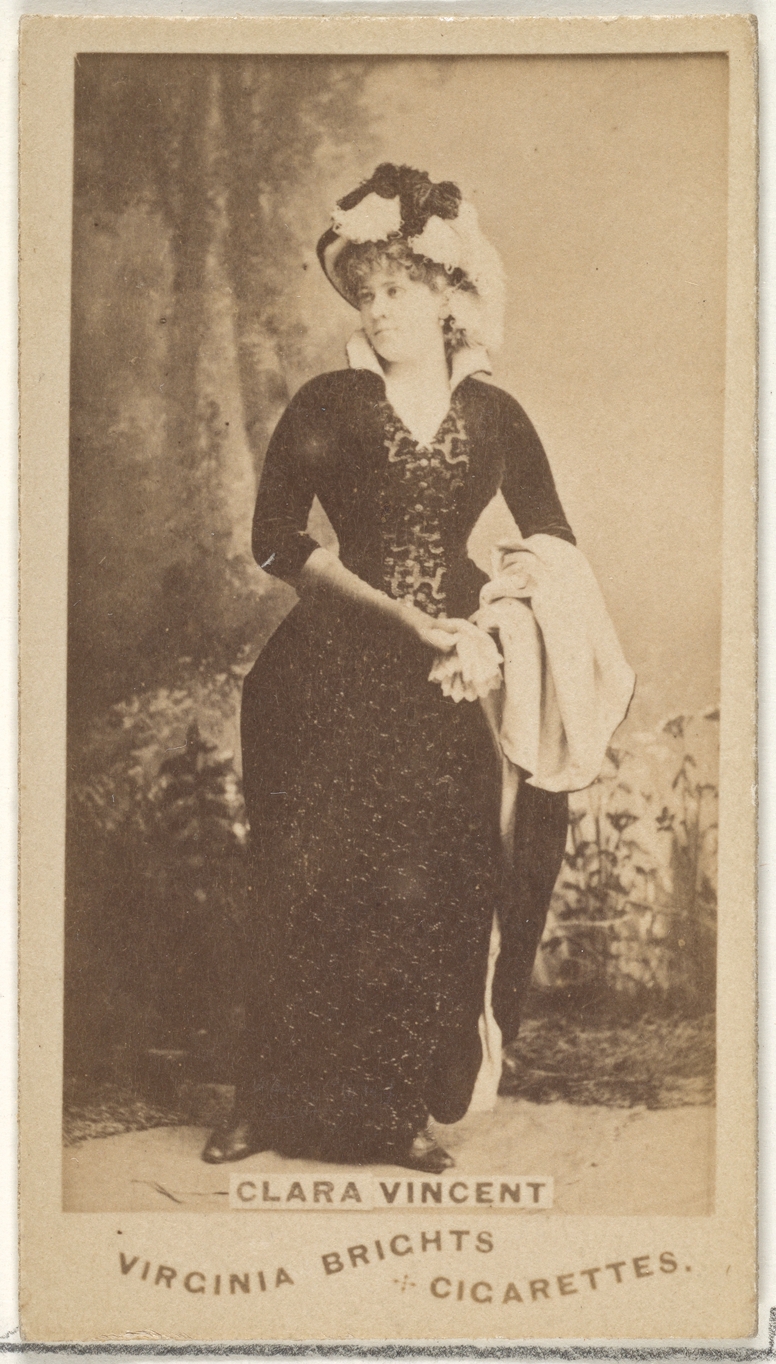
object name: photograph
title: Clara Vincent, from the Actors and Actresses series (N45, Type 1) for Virginia Brights Cigarettes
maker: allen & ginter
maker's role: publisher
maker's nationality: american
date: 1888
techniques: albumen silver print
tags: portraits,women,actresses